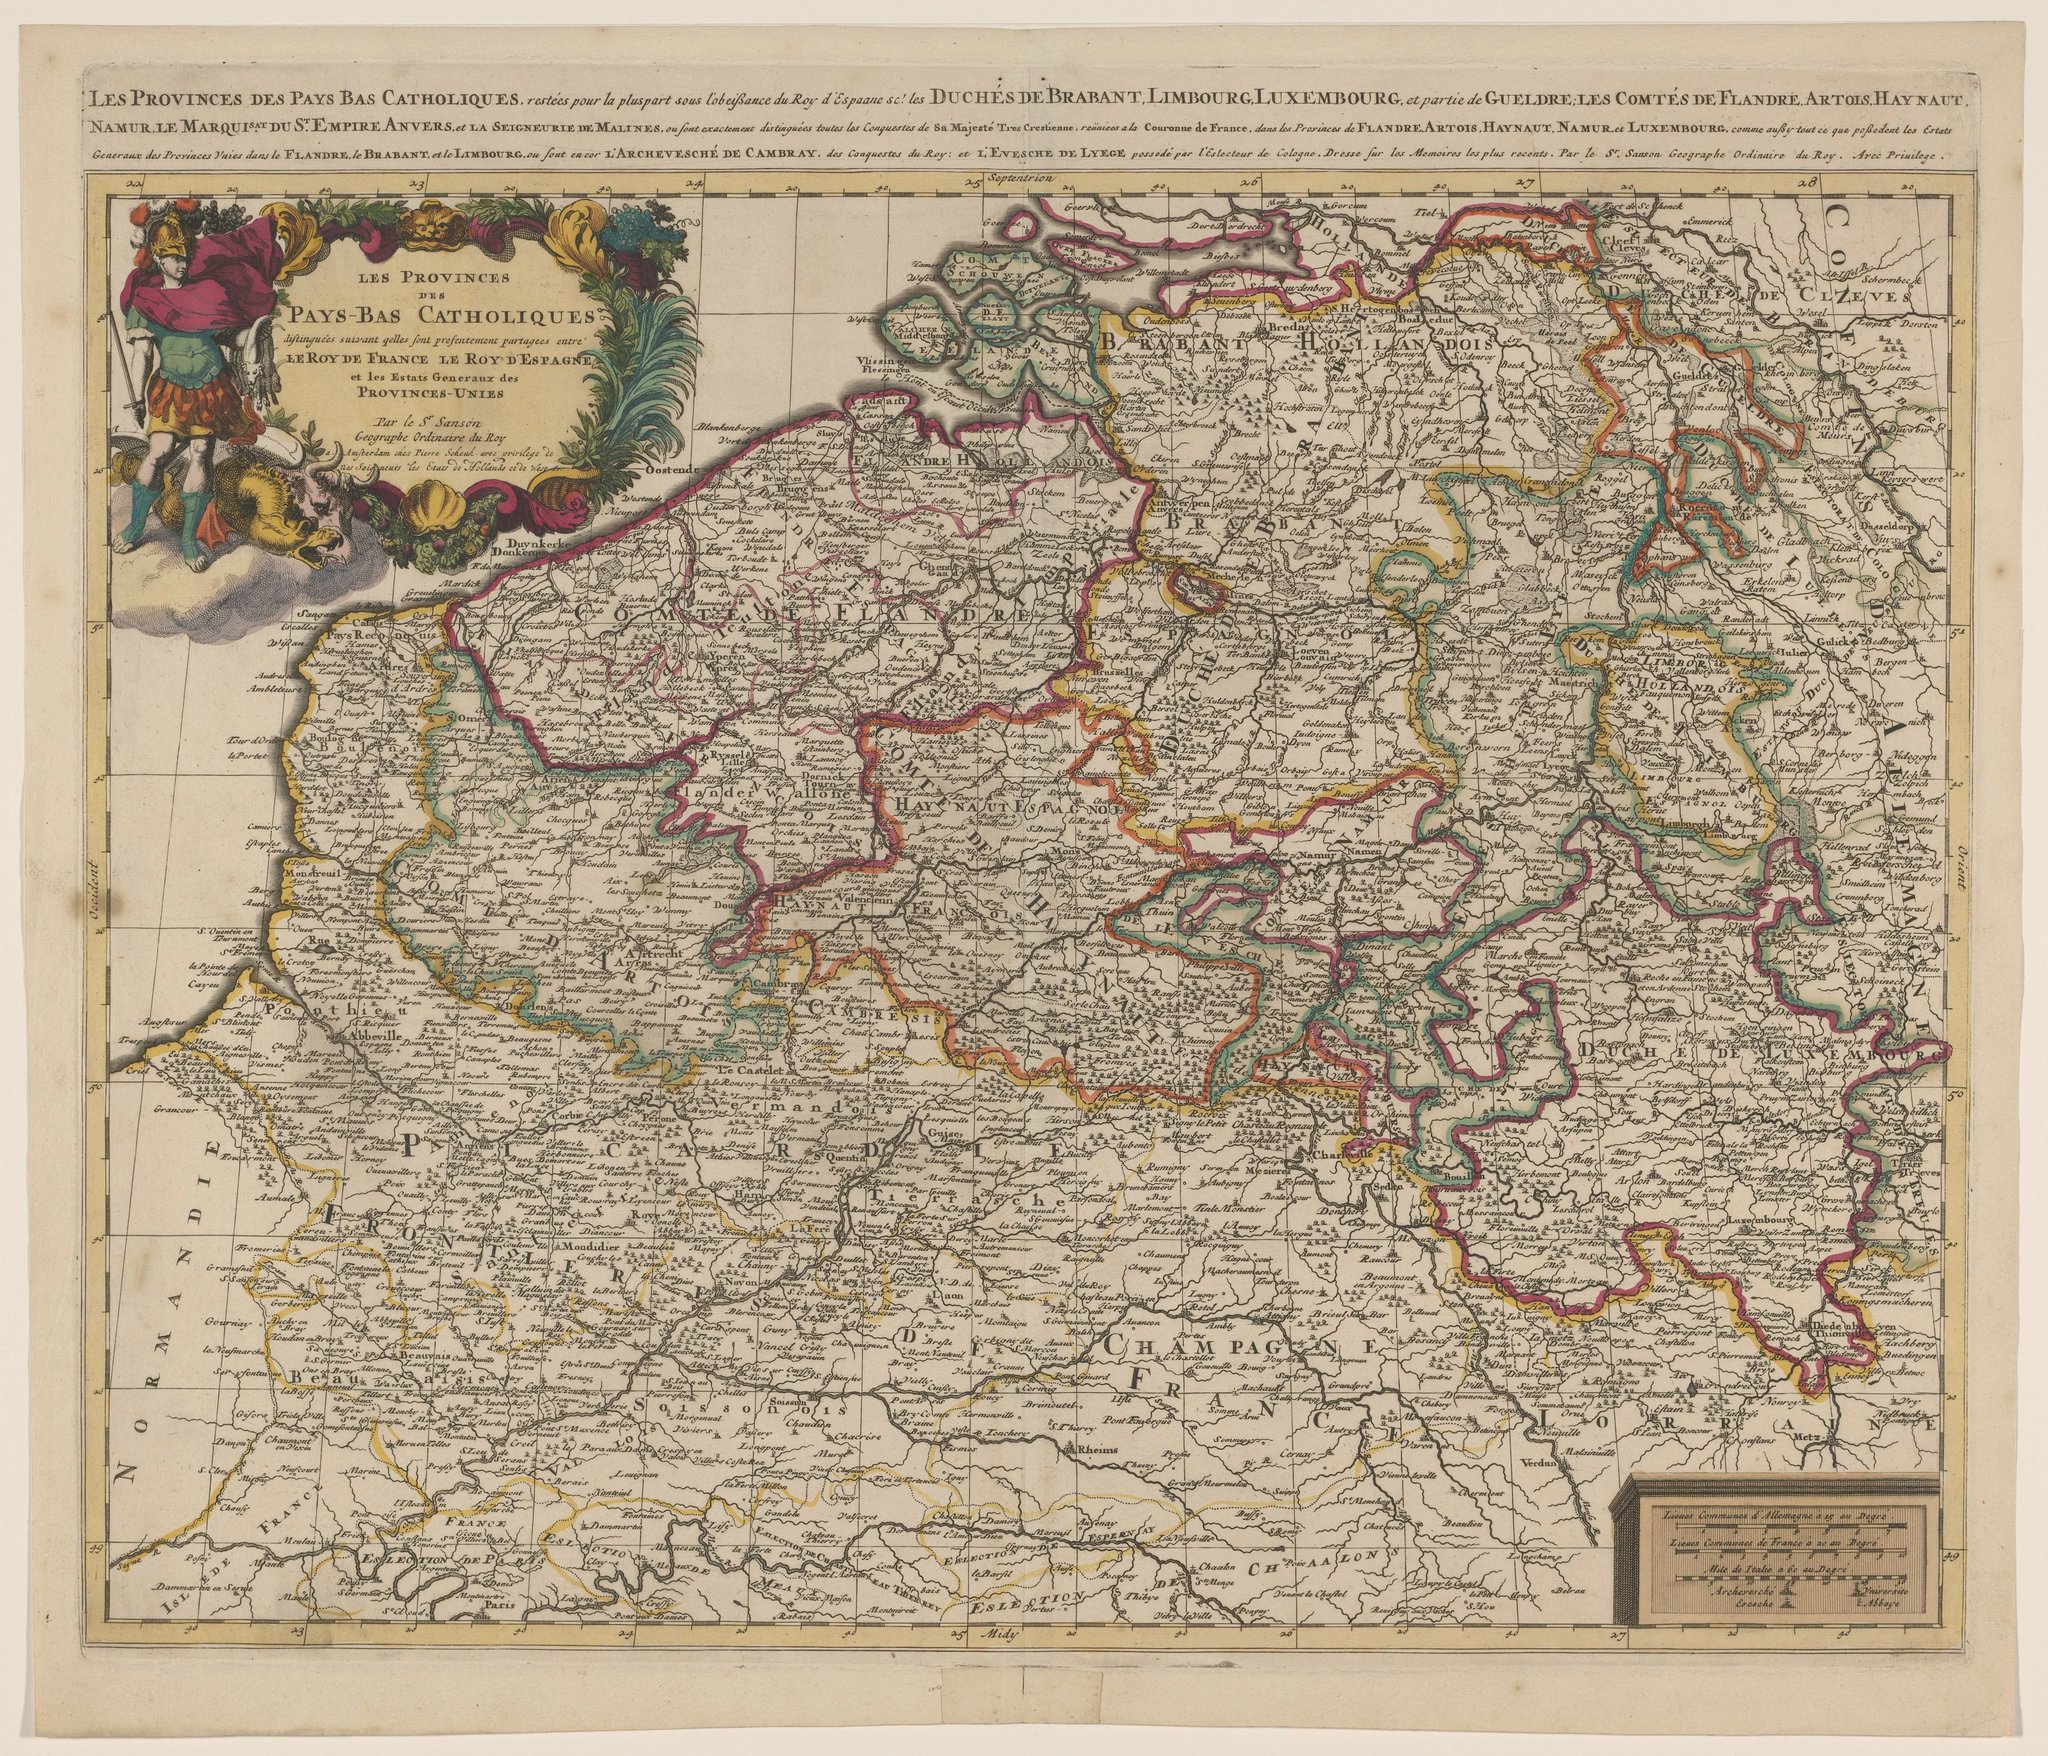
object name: print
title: Kaart van de Zuidelijke Nederlanden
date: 1675-1711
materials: paper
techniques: engraving, etching, hand coloring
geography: amsterdam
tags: maps of separate countries or regions, southern netherlands, belgium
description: Kaart van de Zuidelijke Nederlanden. De titel boven de kaart. Linksboven een cartouche met tweede titel. Rechtsonder een cartouche met legenda en drie schaalstokken: 7 Lieues Communes d'Allemagne à 15 au Degré / 10 Lieues Communes de France à 20 au Degré / 30 Mile de Italie a 60 au Degré. De kaart is voorzien van een coördinaten-net en een gradenverdeling langs de randen.